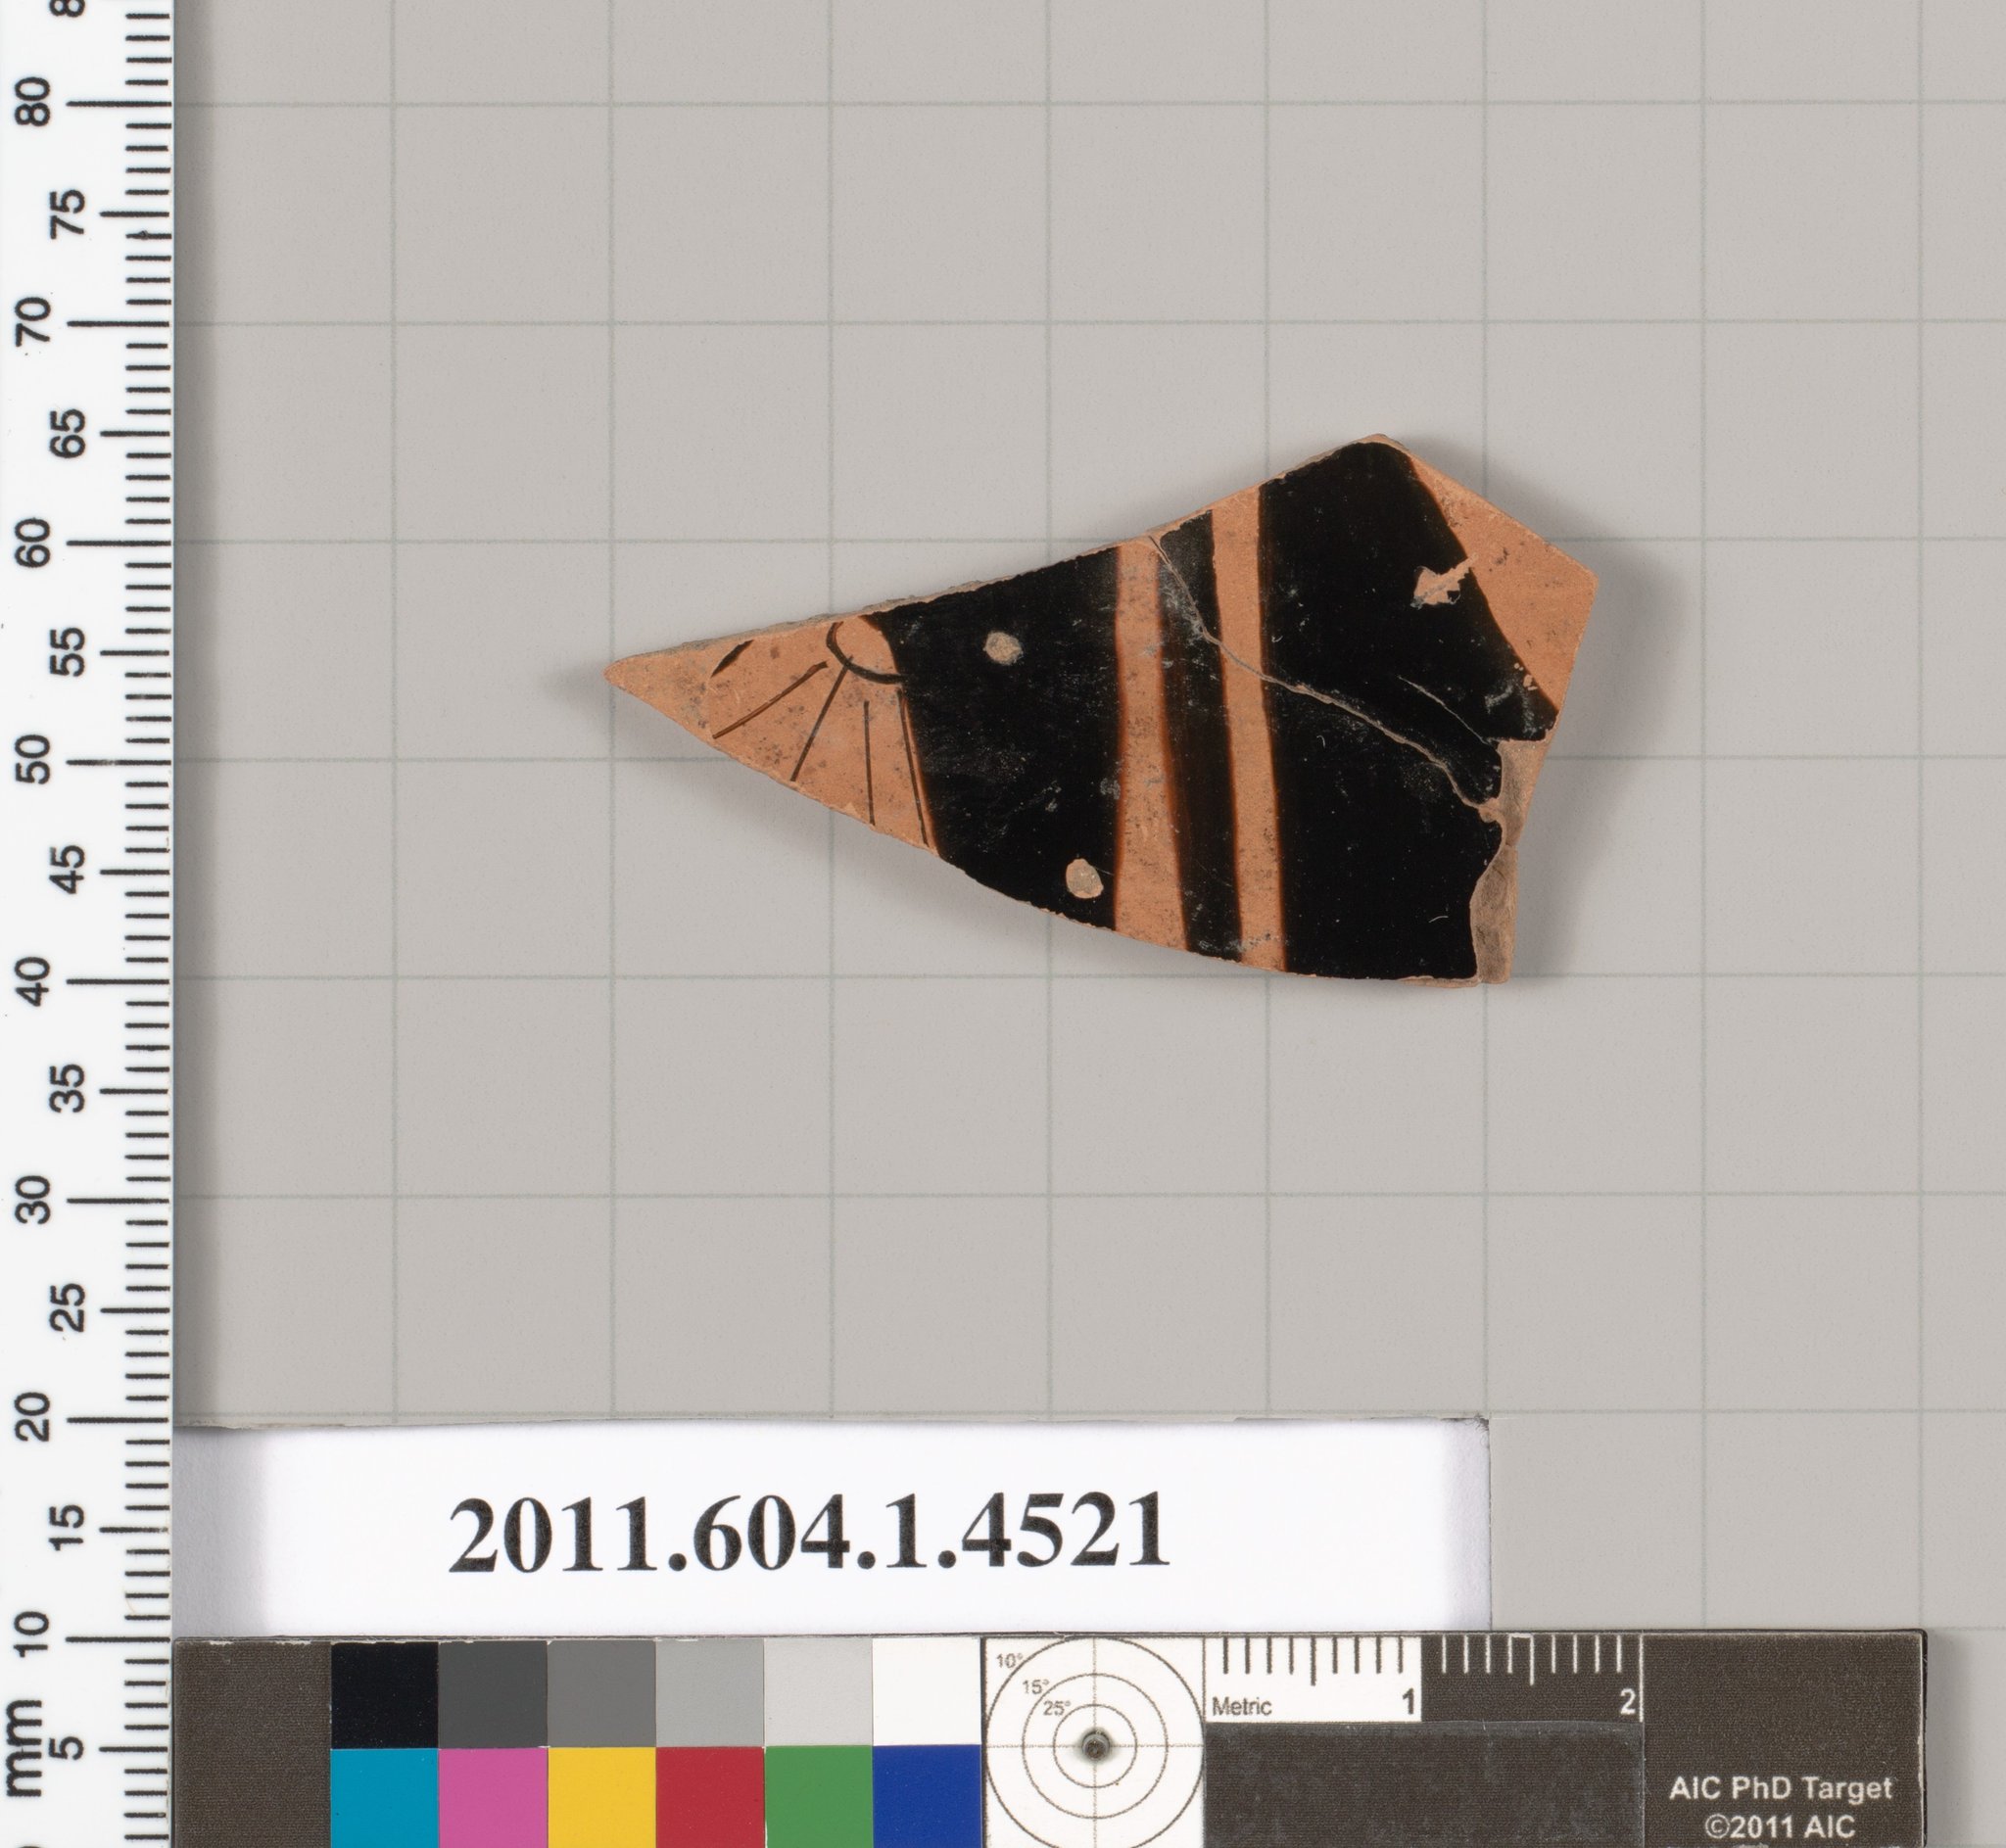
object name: kylix fragment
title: Terracotta fragment of a kylix (drinking cup)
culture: greek, attic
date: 467-435 BCE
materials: terracotta